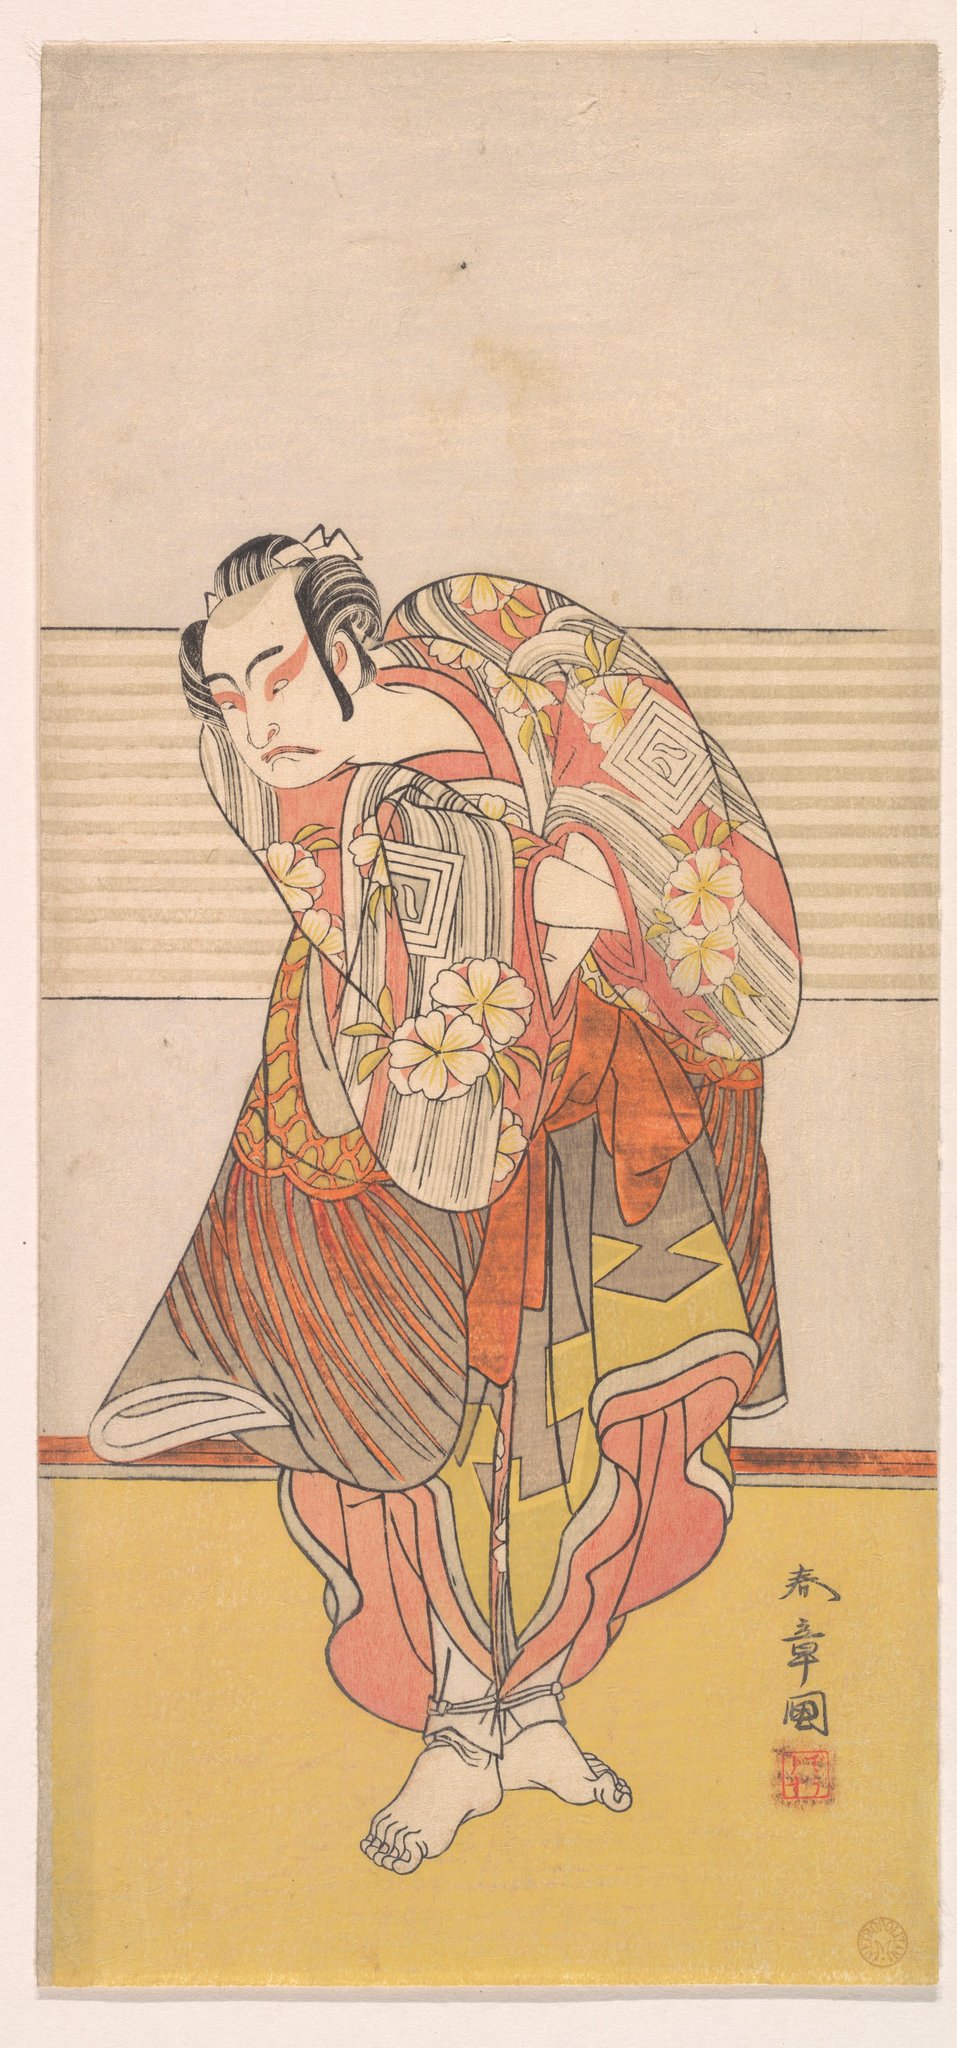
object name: woodblock print nishiki e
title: The Second Ichikawa Yaozo as a Man Standing with His Arms Crossed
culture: japanese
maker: katsukawa shunshō 勝川春章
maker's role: artist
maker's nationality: japanese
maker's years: 1726-1792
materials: ink, paper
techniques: nishiki e, woodblock print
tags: men,actors